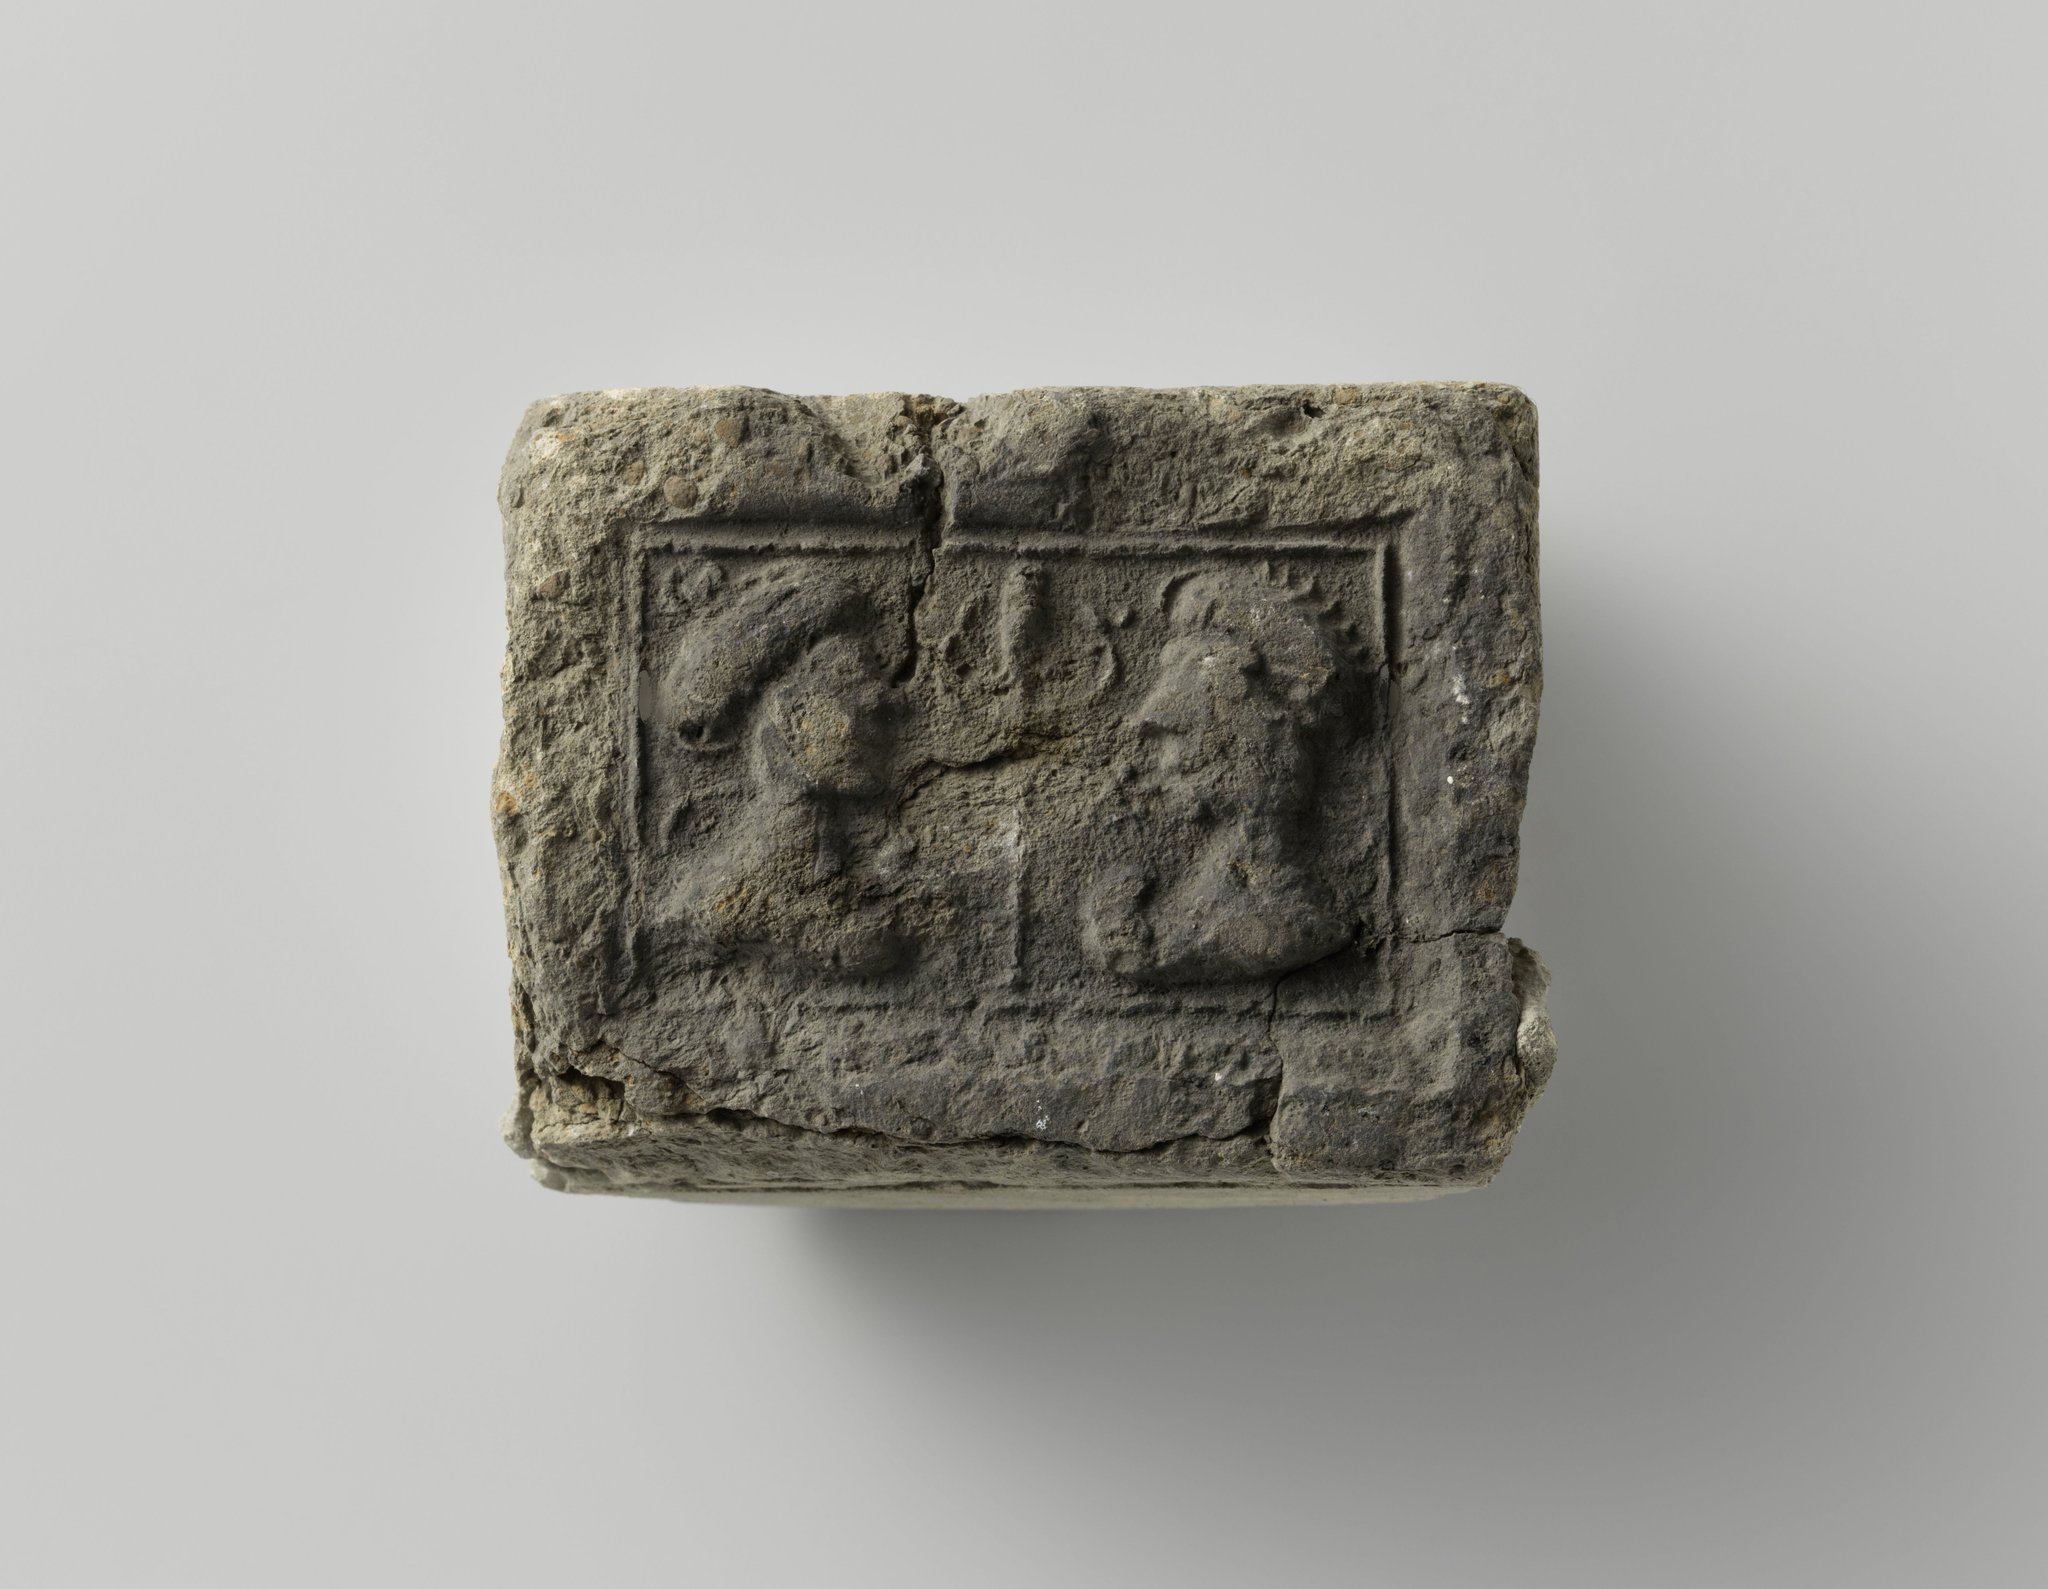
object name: hearthstone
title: Haardsteen met afbeelding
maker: Anonymous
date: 1400-1950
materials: earthenware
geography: southern netherlands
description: Haardsteen met een afbeelding van twee manshoofden.